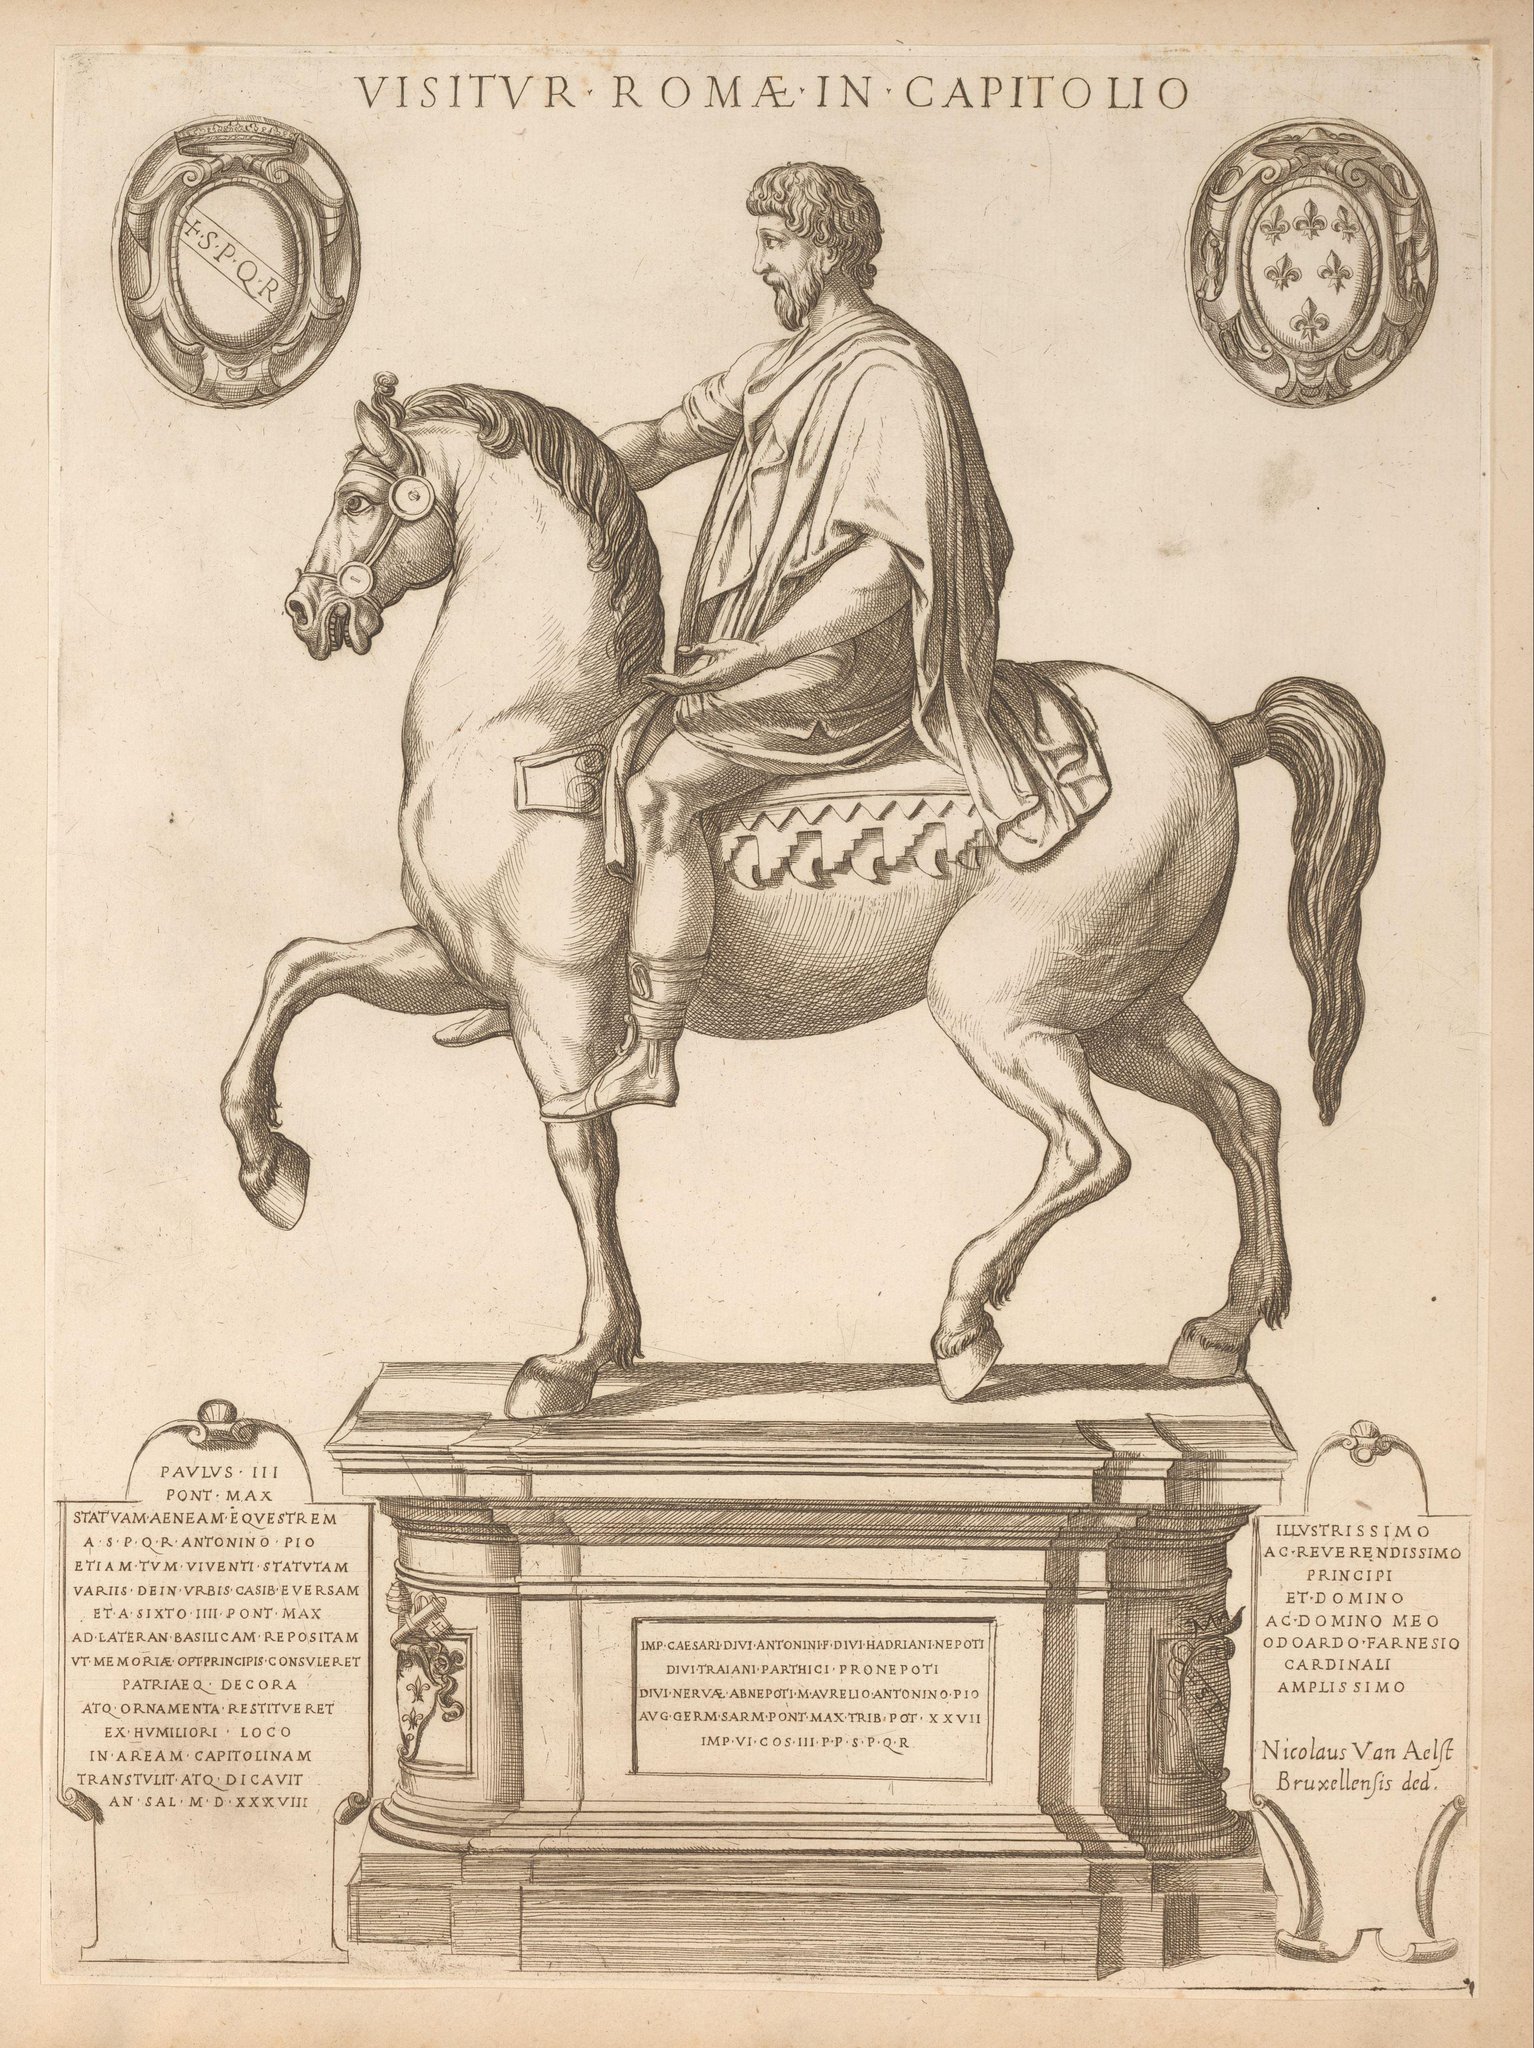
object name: print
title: Speculum Romanae Magnificentiae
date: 1537-1613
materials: paper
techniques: etching, intaglio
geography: italy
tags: piece of sculpture, reproduction of a piece of sculpture, equestrian statue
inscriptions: number: ‘1’, number: ‘82’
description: Deze prent behoort tot het prentcorpus dat bekend staat als de ‘Speculum Romanae Magnificentiae’ (‘Spiegel van Romeinse pracht’). Dit corpus, bestaande uit prenten met voorstellingen van kunstwerken en gebouwen uit het antieke en het moderne Rome, vond zijn oorsprong bij uitgevers Antonio Salamanca en Antonio Lafreri. Deze twee buitenlandse uitgevers bundelden hun krachten te Rome in de periode 1553-1563. Hun prenten werden al snel razend populair bij toeristen en verzamelaars, die de prenten individueel of in grote groepen aanschaften. Grote groepen Speculum-prenten werden vaak op aanvraag samengebonden in albums. Er zijn verschillende Speculum-albums overgeleverd die allemaal verschillen van inhoud. Tussen 1573 en 1577 gaf Antonio Lafreri een speciale titelpagina uit (met de titel ‘Speculum Romanae Magnificentiae’) die mensen voor hun verzamelingen konden voegen. Het overlijden van Lafreri in 1577 betekende niet het einde van het corpus. Een groot deel van de koperplaten ging over op Claudio en Stefano Duchetti. De rest raakte verspreid over verschillende andere uitgevers. De populariteit van de Speculum-prenten wist nog geruime periode uitgevers te inspireren tot het laten maken van kopieën en het toevoegen van nieuwe prenten aan het corpus.